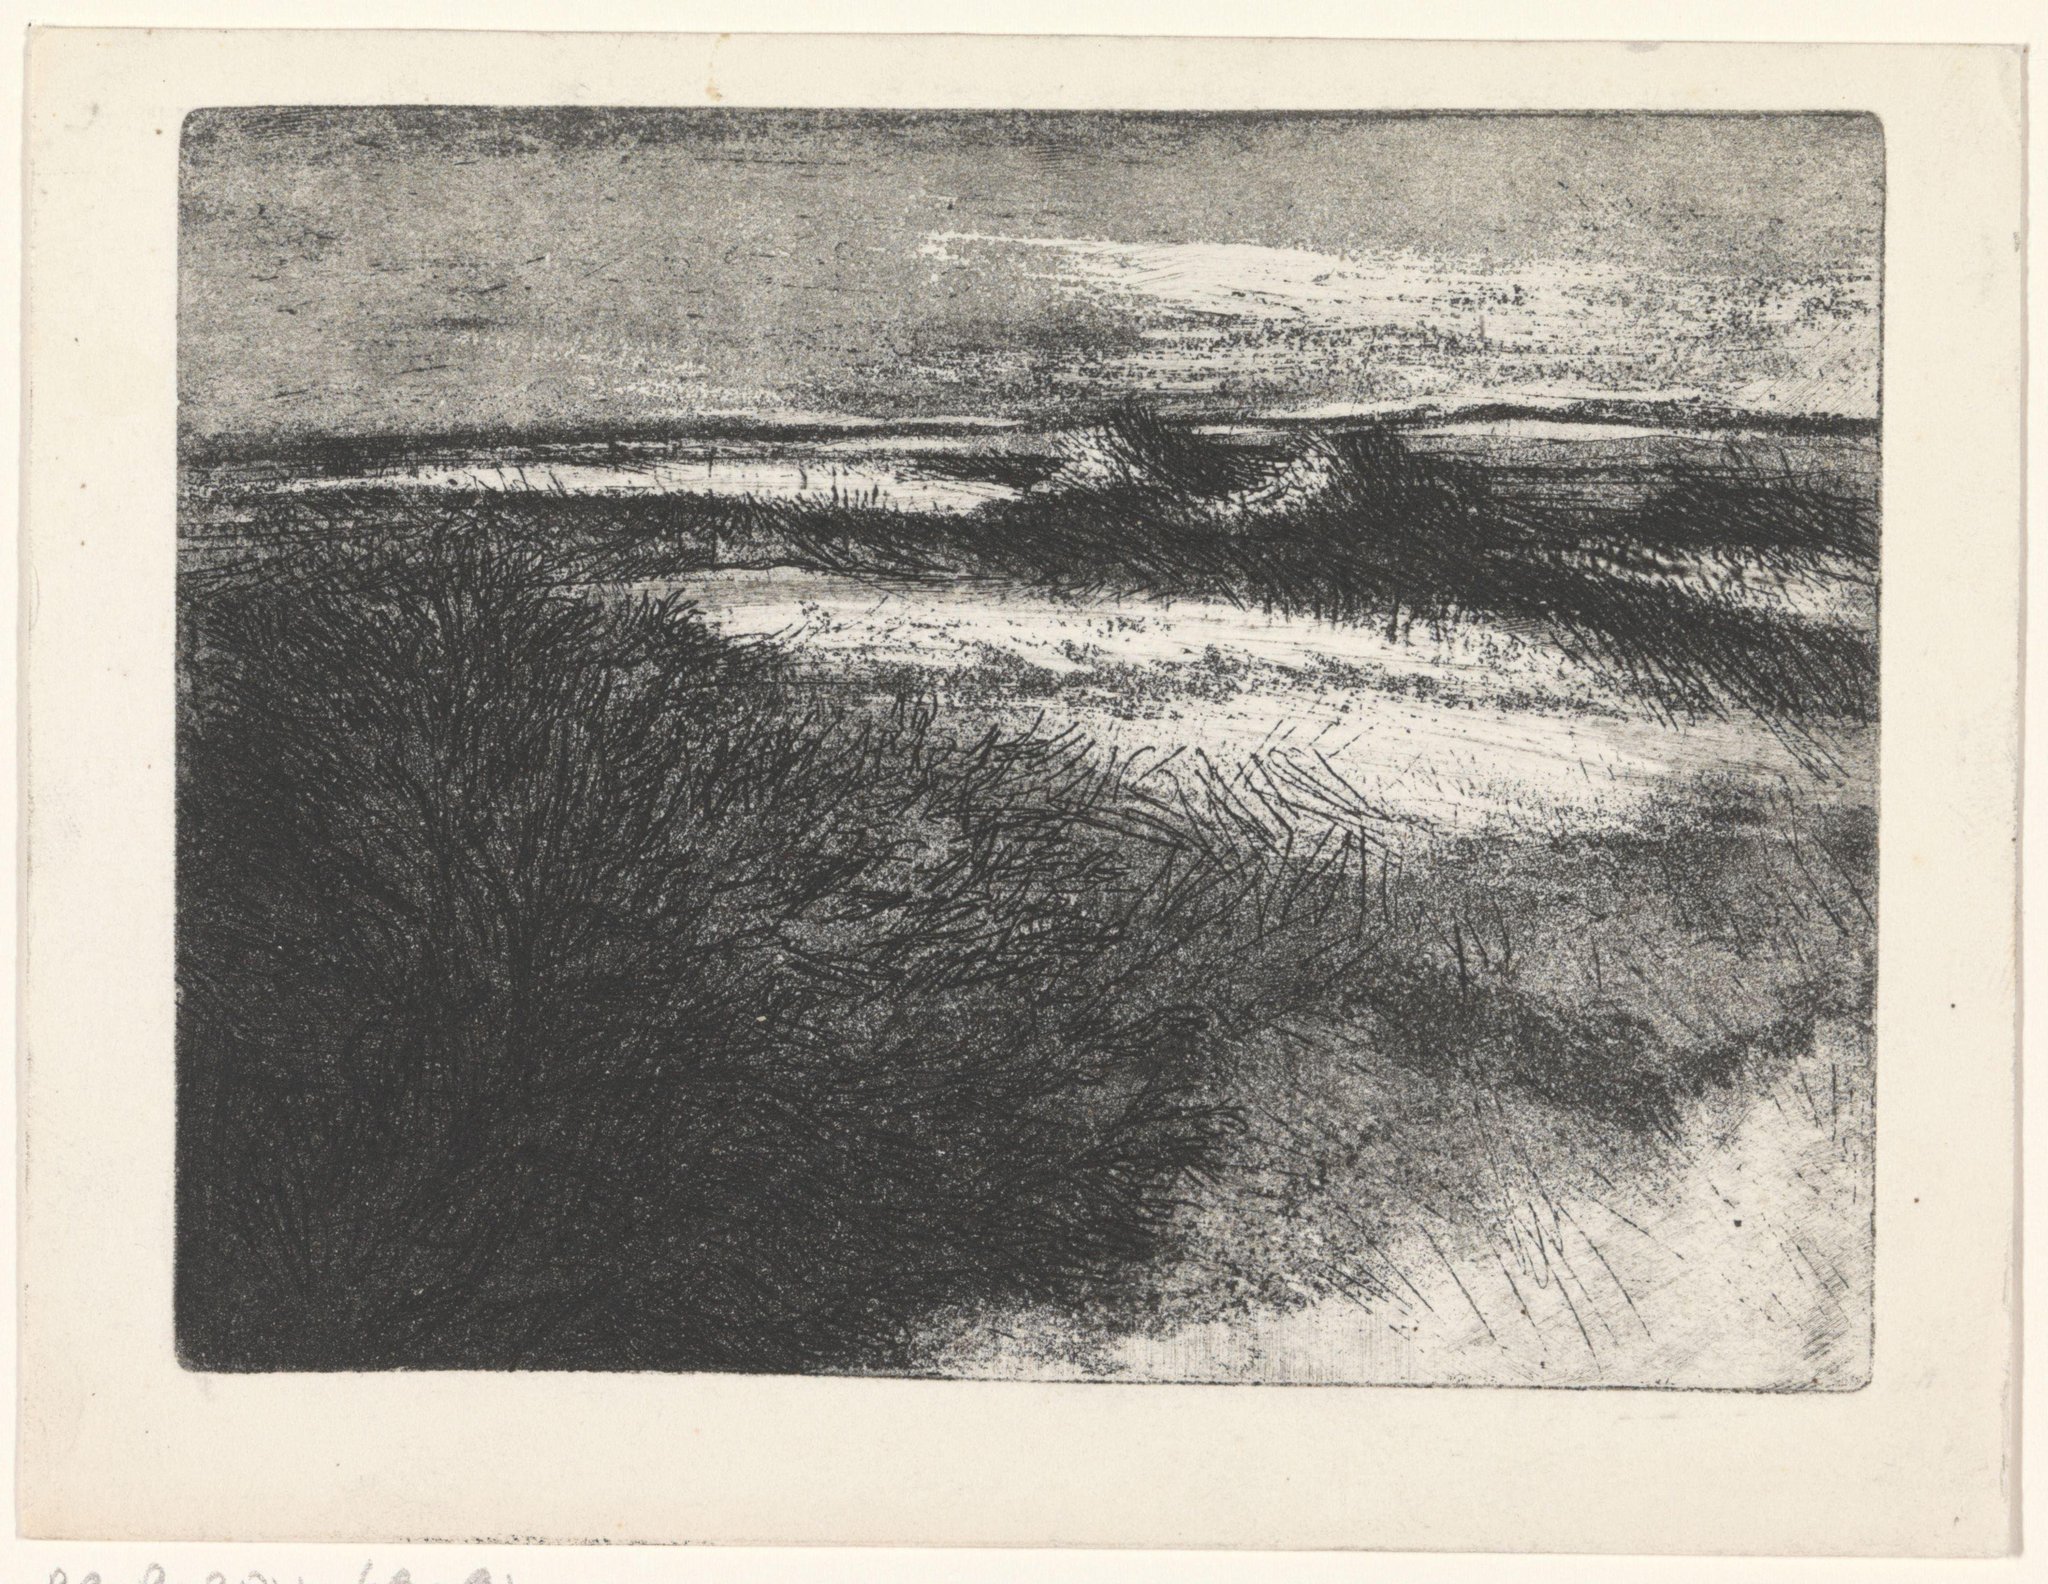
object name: print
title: Duinlandschap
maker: kees stoop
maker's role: draughtsman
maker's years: 1929-2019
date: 1975-1976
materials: paper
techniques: aquatint, etching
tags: dunes (sea not visible); in the dunes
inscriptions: signature: ‘KEES STOOP’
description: Duinlandschap met helmgras, links aan de horizon de zee.